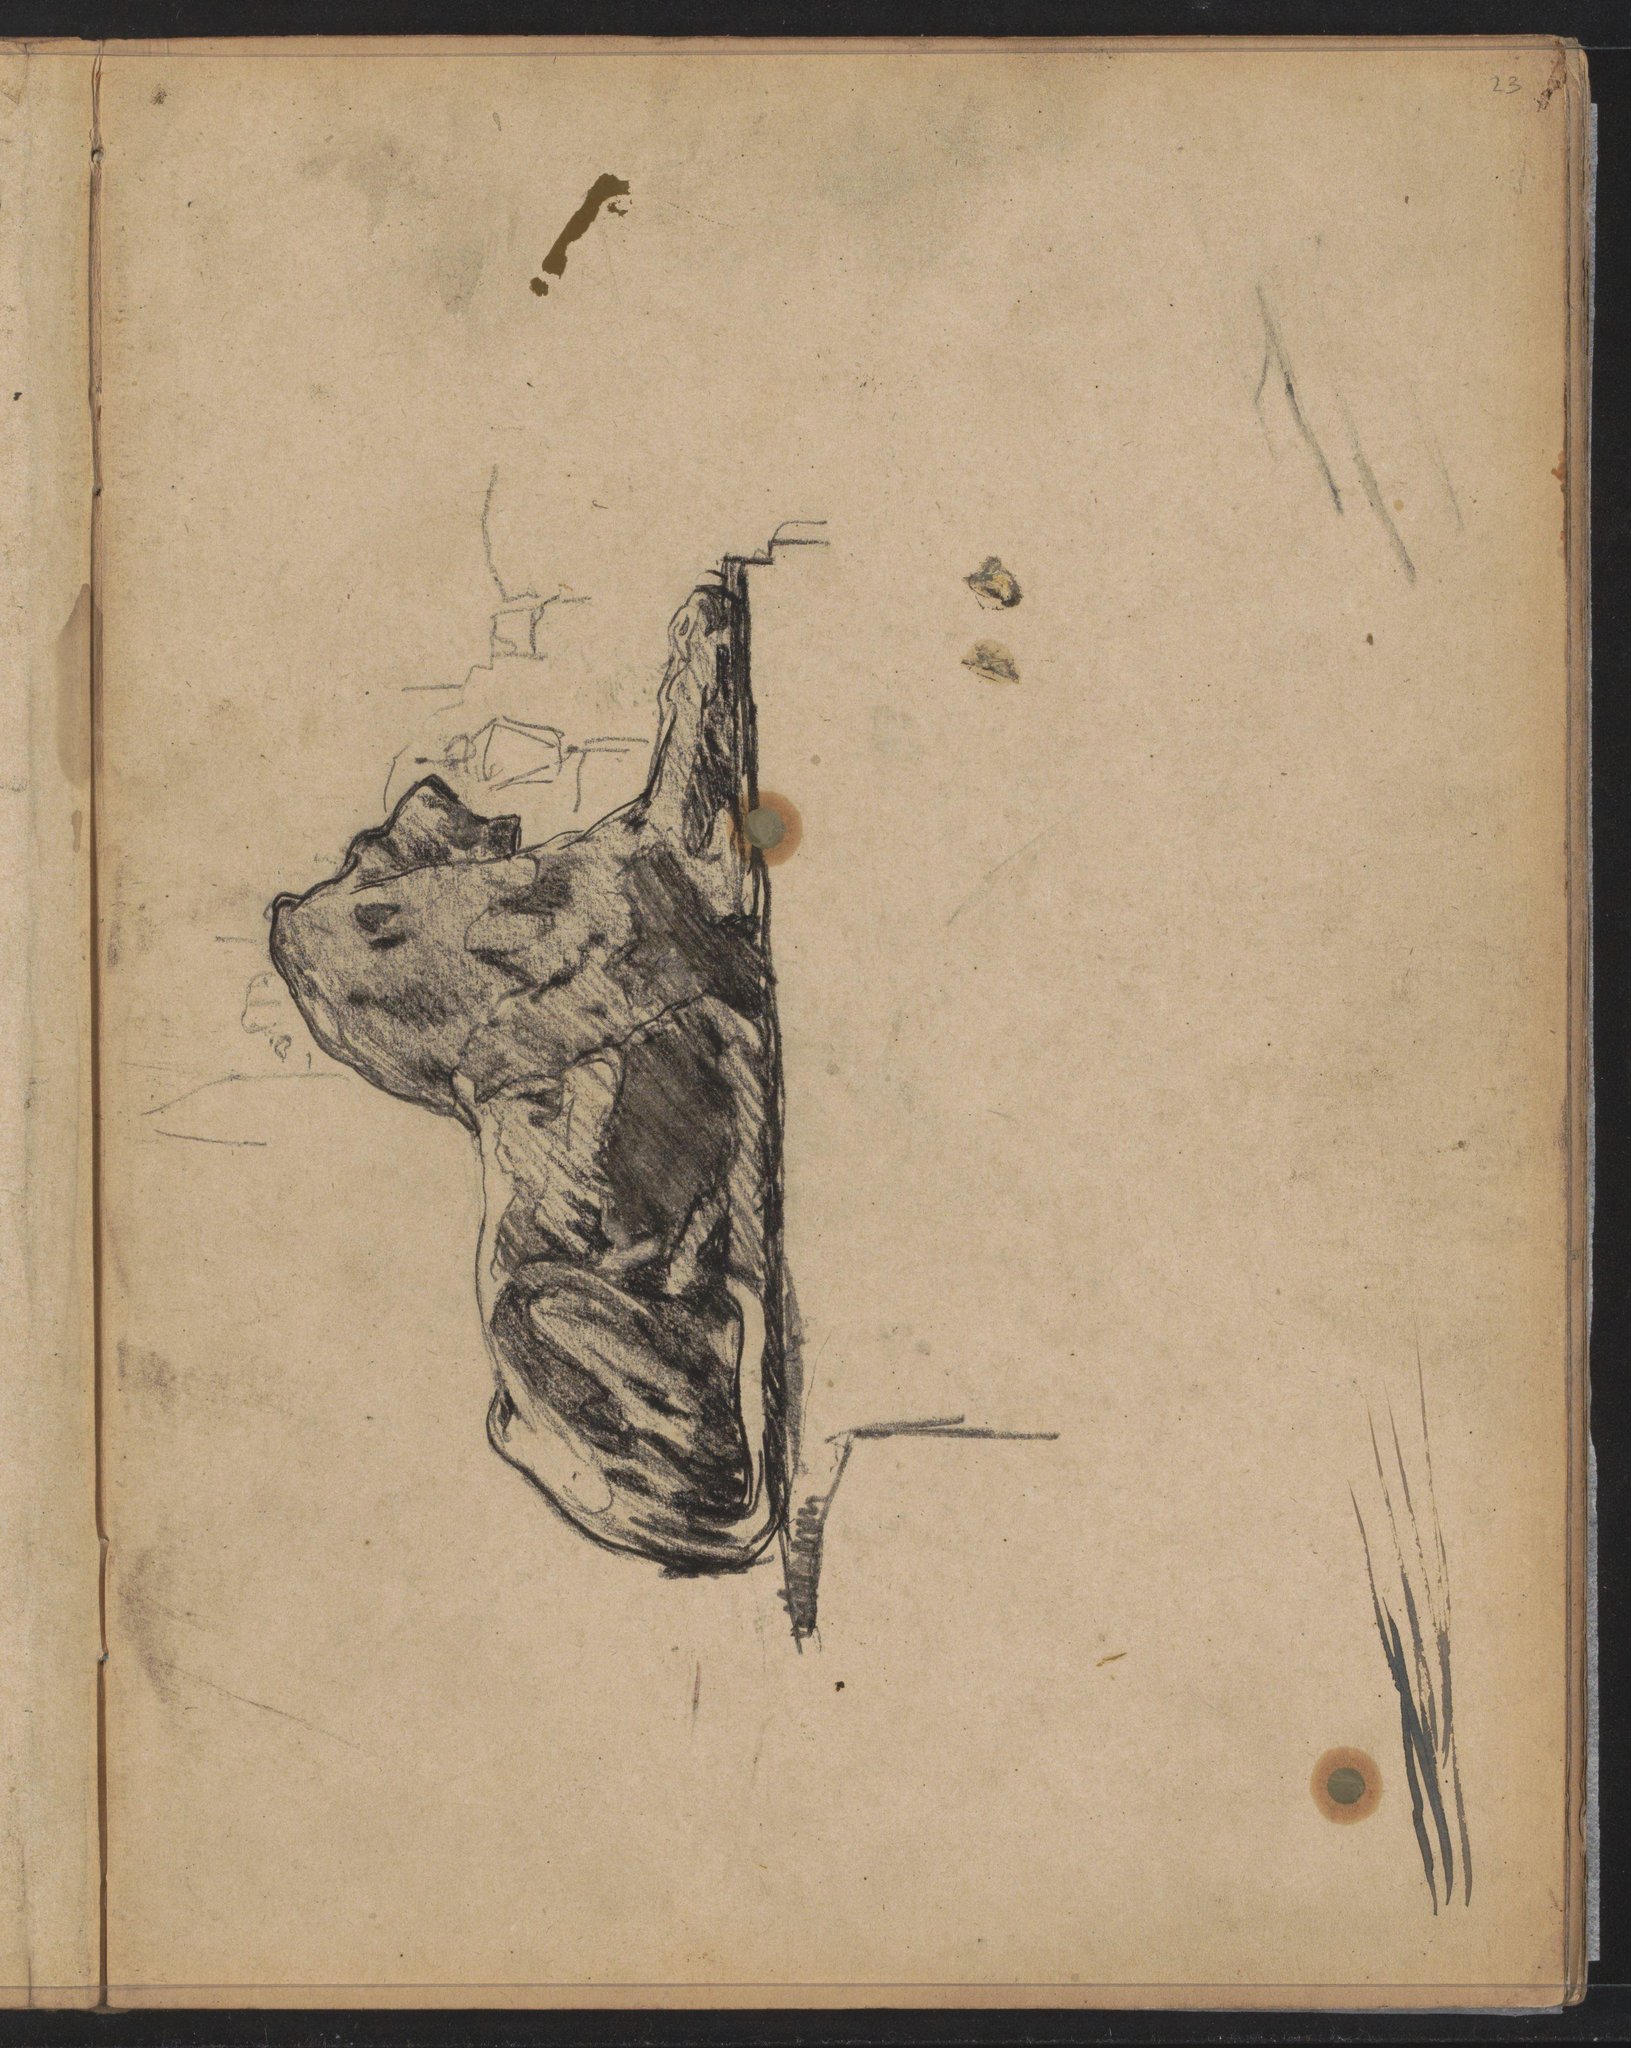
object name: sketchbook leaf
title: Bronzen leeuw aan de voet van Nelson's Column op Trafalgar Square, Londen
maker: willem witsen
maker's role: draughtsman, painter, print maker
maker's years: 1860-1923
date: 1888-1890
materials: chalk, paper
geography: london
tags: square, place, circus, etc., monument, statue, beasts of prey, predatory animals: lion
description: Op de achtergrond gebouwen. Pagina 23 uit een schetsboek met 40 bladen.